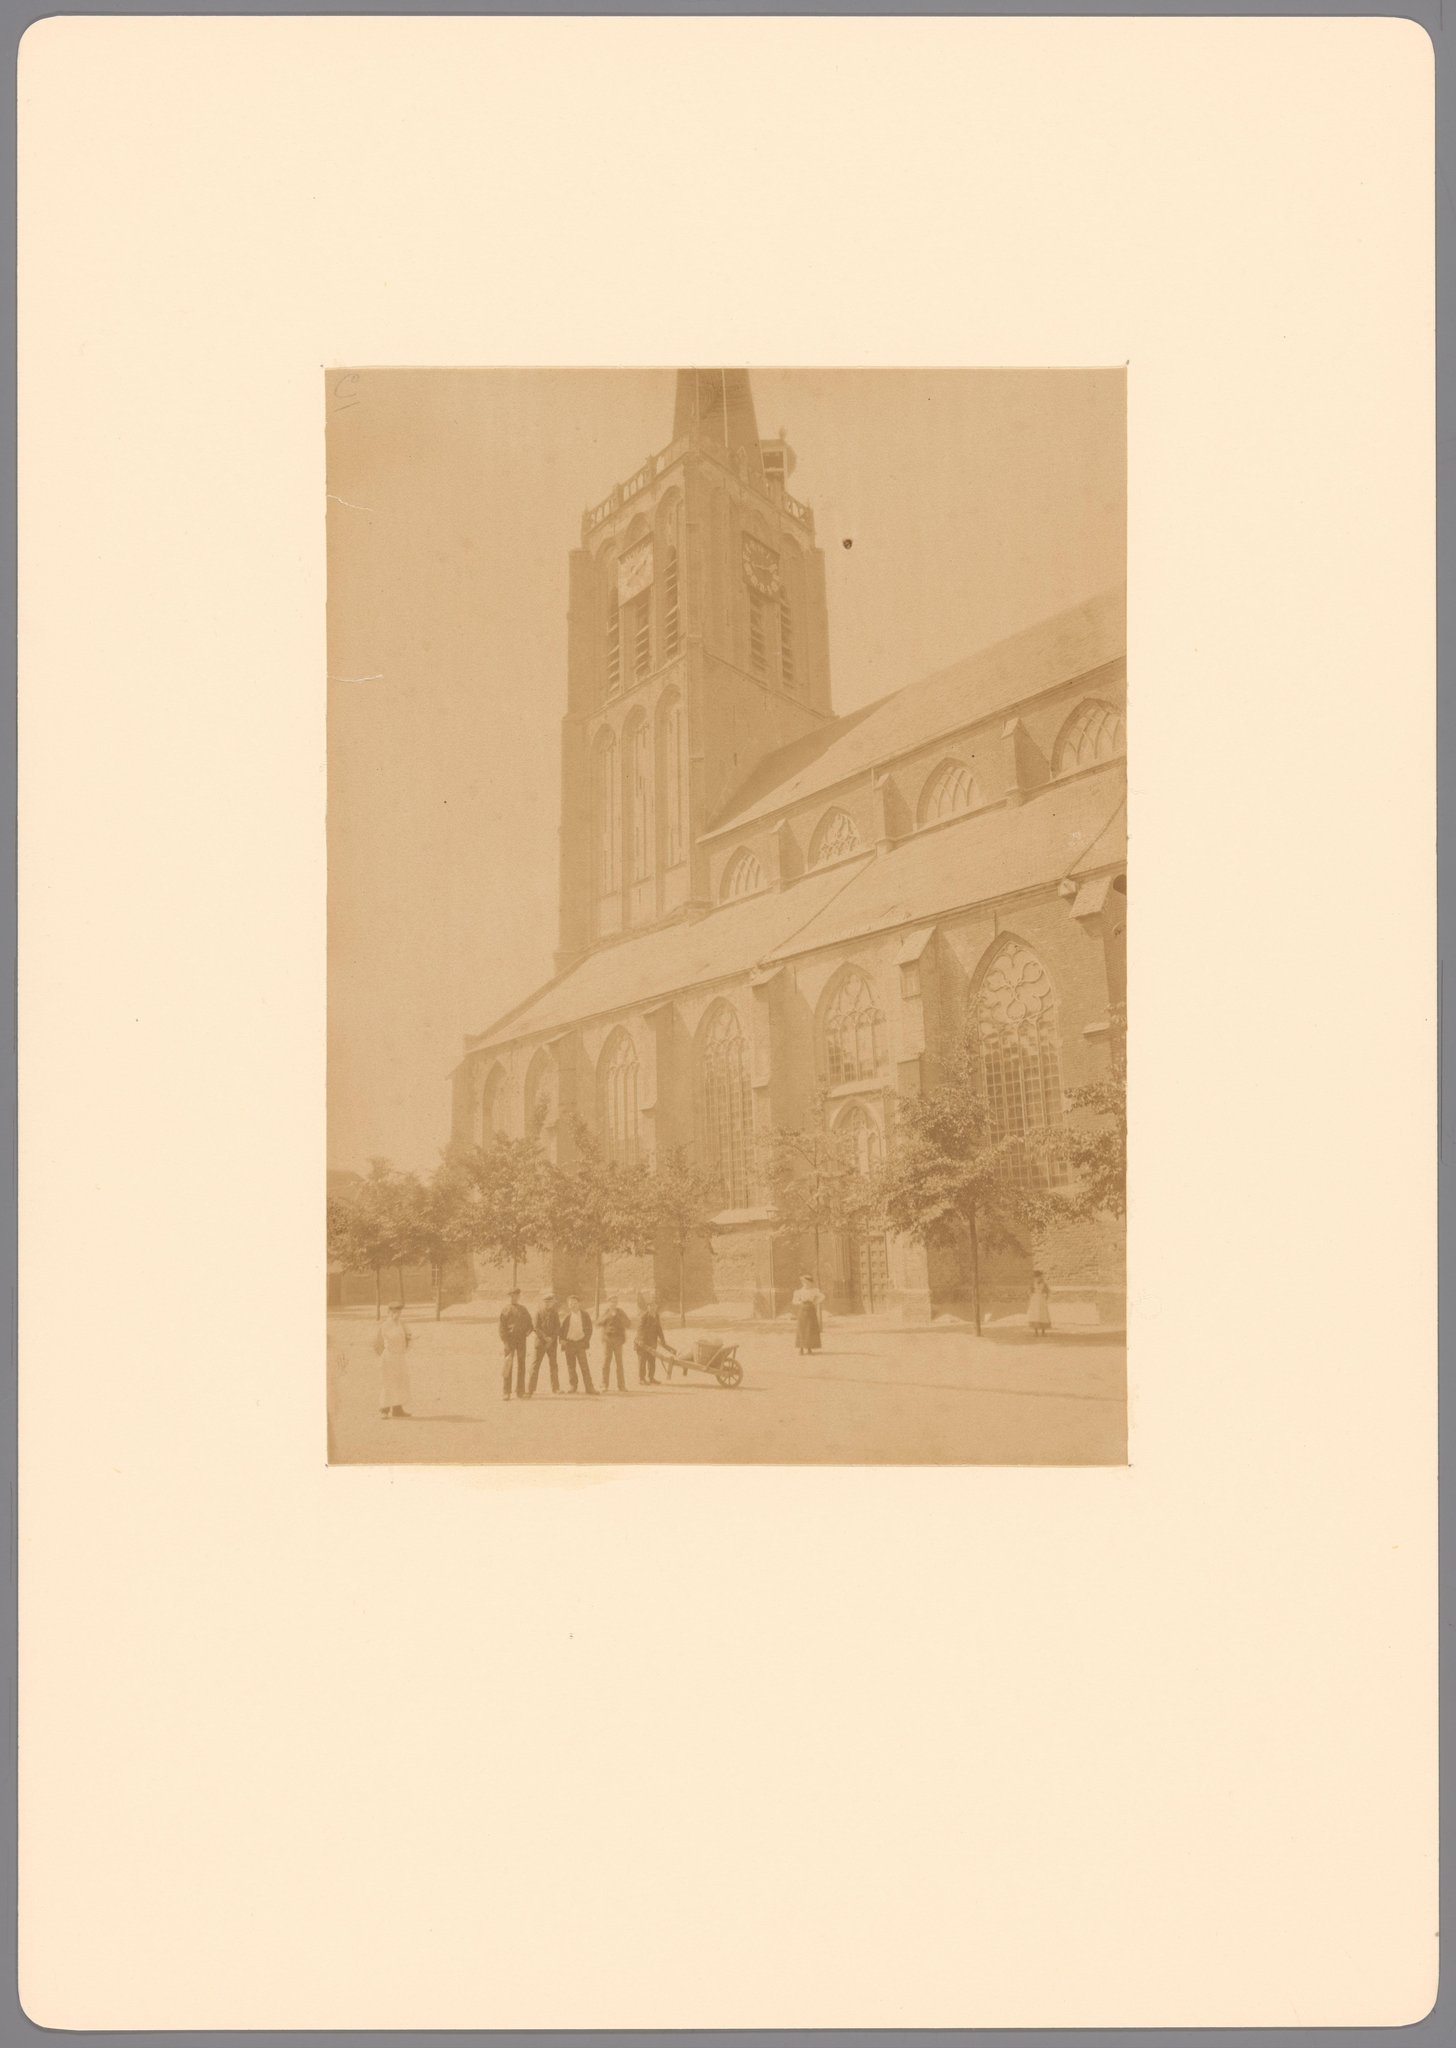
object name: photograph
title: Gezicht op de Grote of Martinikerk te Doesburg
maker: anoniem (monumentenzorg)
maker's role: fotograaf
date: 1899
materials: cardboard, photographic support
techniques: albumen print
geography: doesburg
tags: church (exterior), street (+ city(-scape) with figures, staffage)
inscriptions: annotation: ‘Doesburg/ toren v/d N.H. Kerk’, annotation: ‘C’